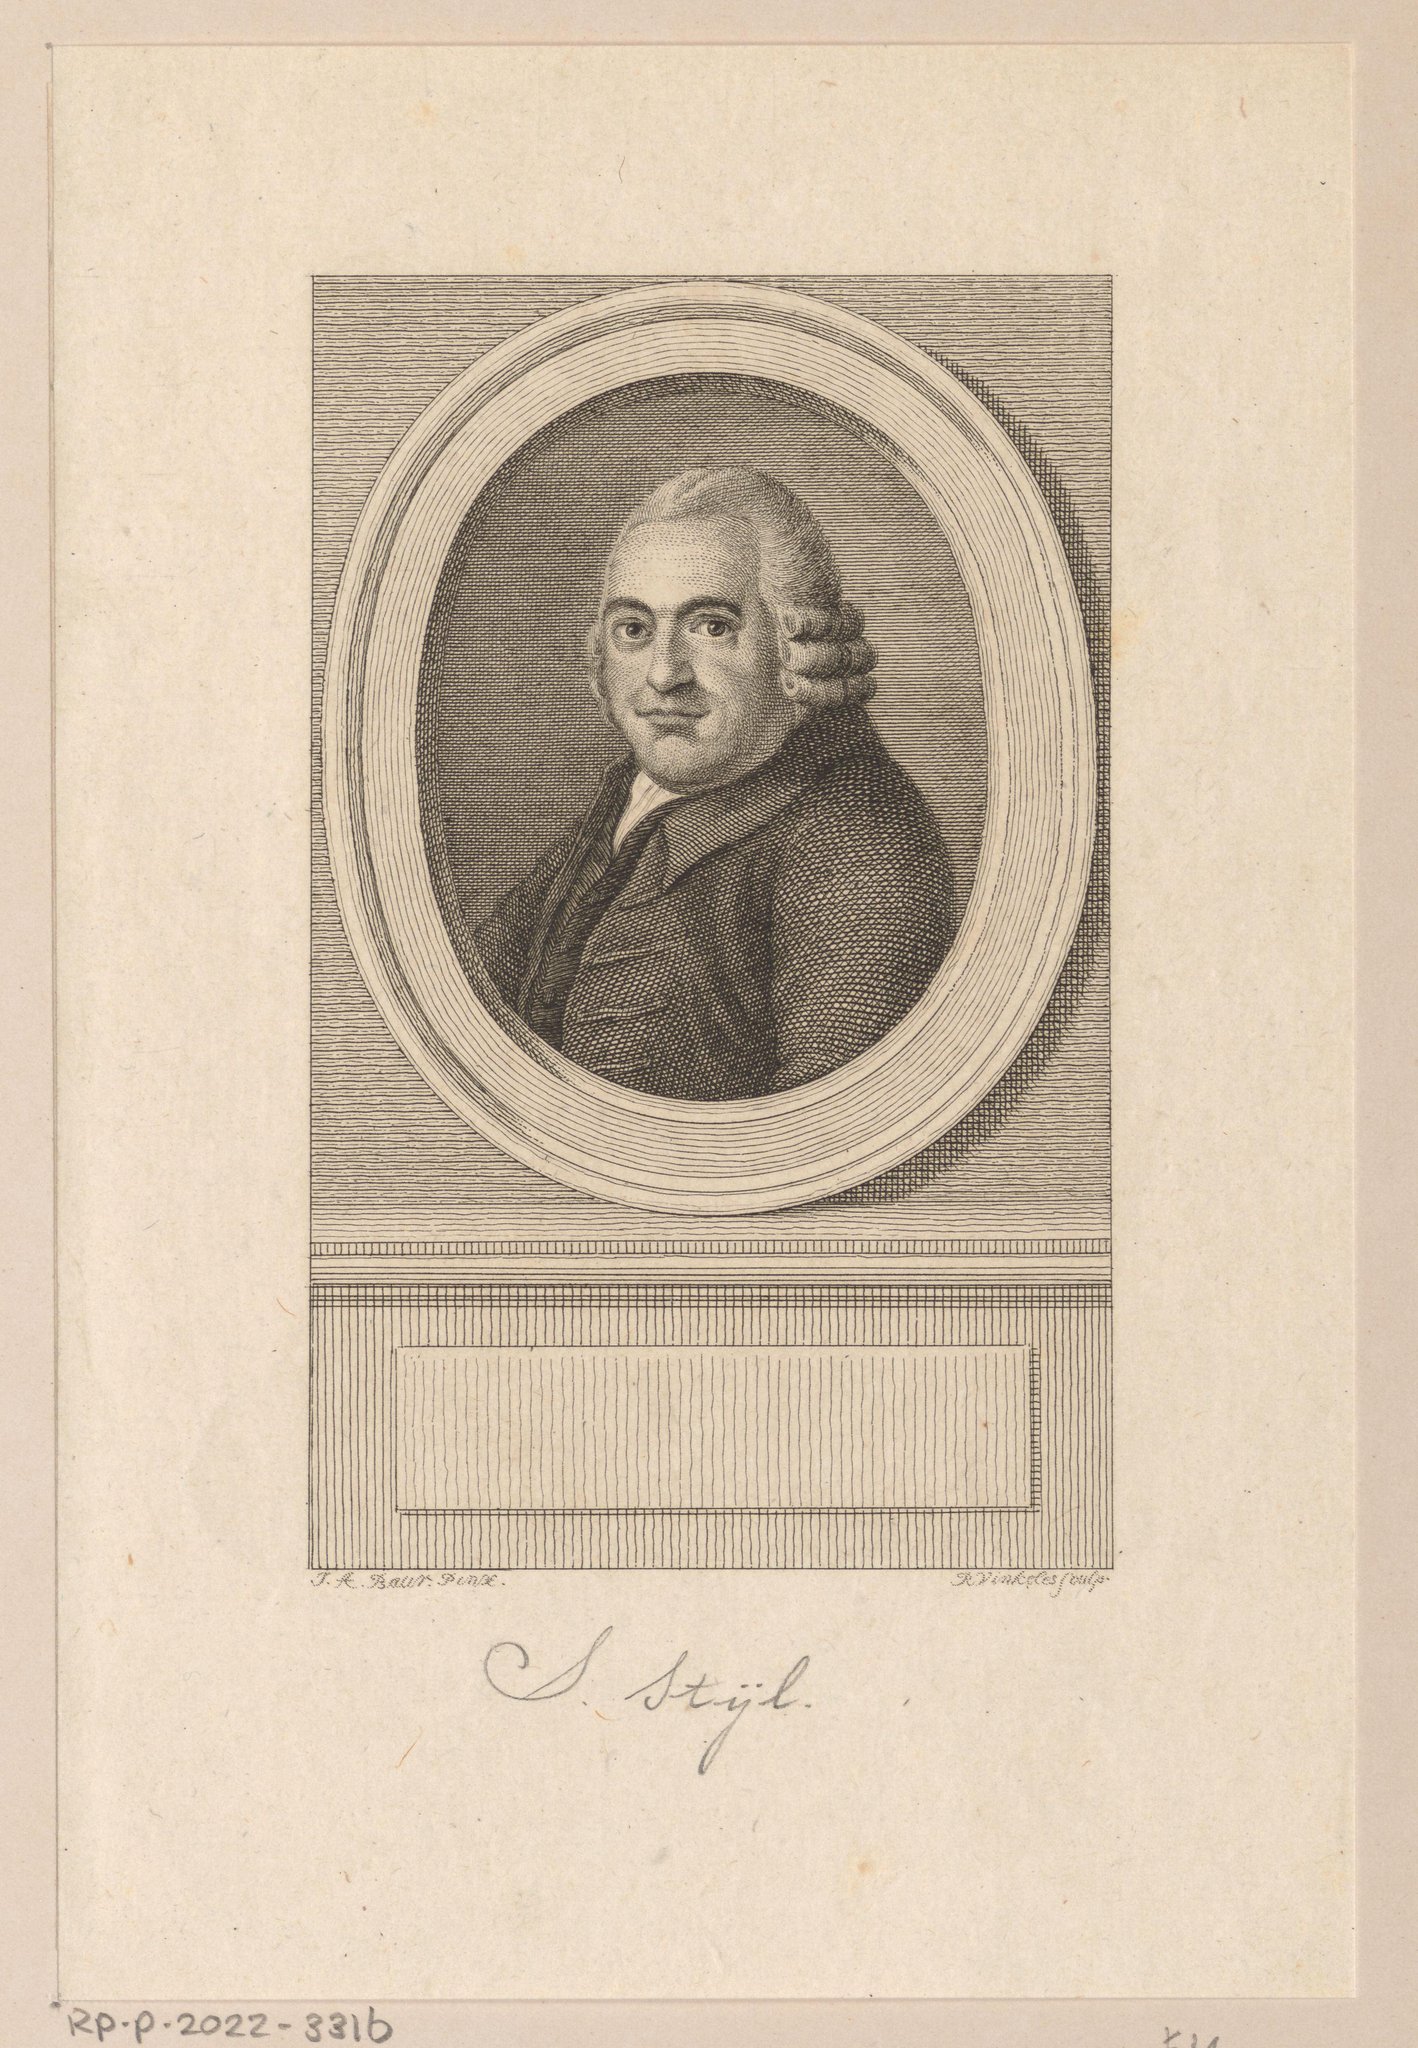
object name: print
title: Portret van Simon Stijl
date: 1806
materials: paper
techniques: etching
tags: harlingen, simon stijl, historical persons, writer, poet, author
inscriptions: collector's mark: Lugt 2166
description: Latere staat van prent gebruikt in: Wagenaar, Jan. Vaderlandsche historie, (...) ten vervolge van Wagenaars Vaderlandsche historie. Amsterdam: Johannes Allart, 1806, dl. 37.